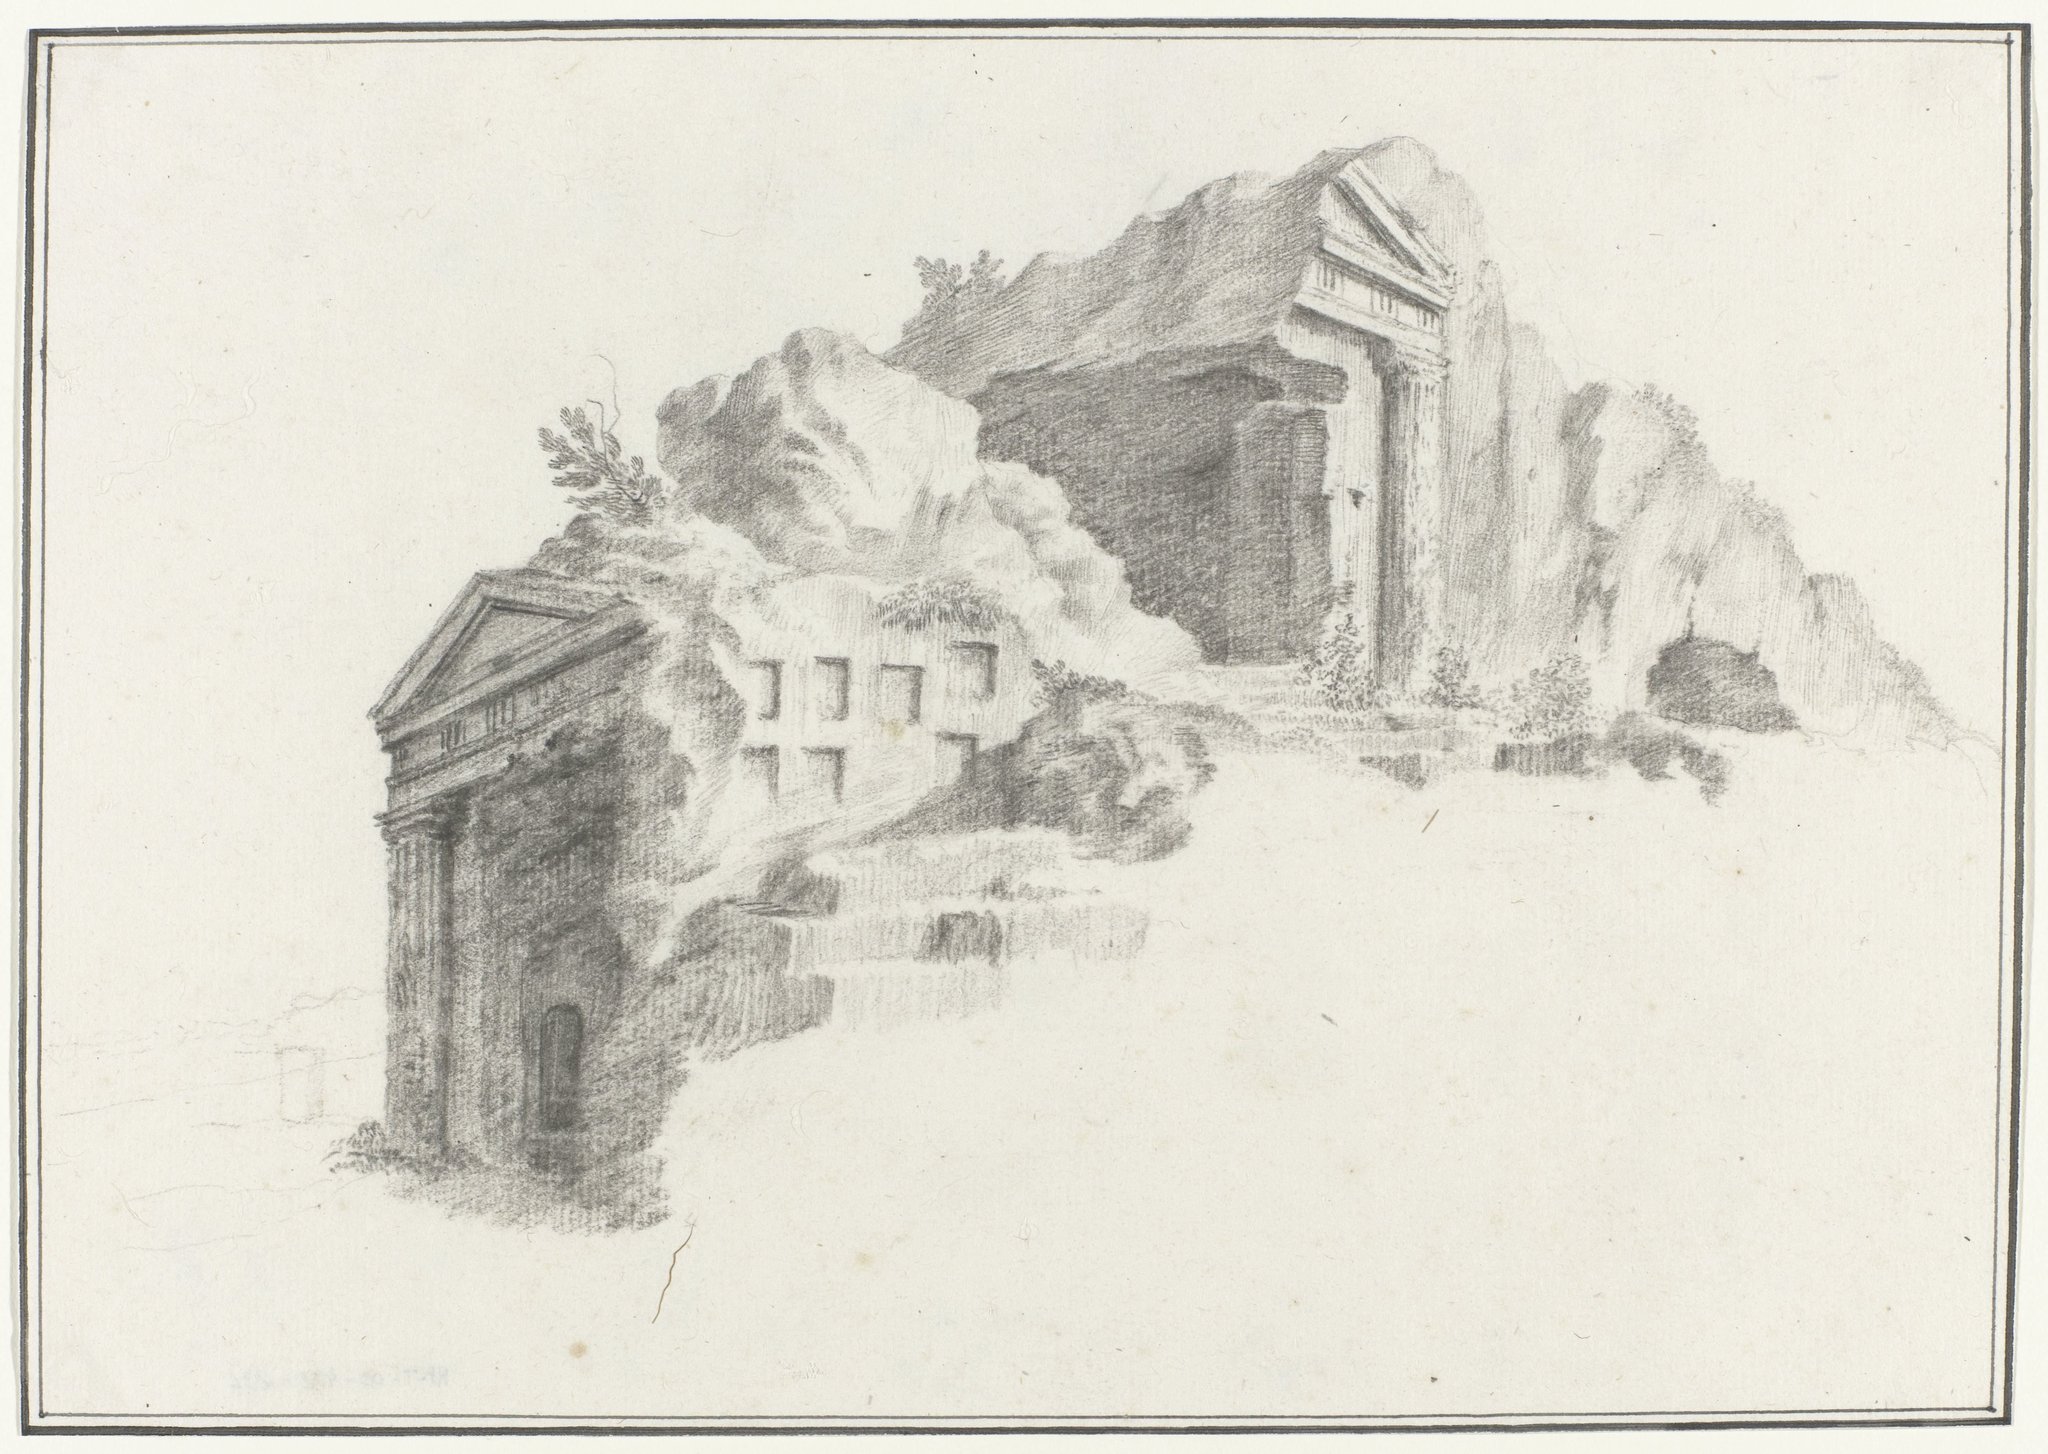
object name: drawing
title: Voyage en Italie, en Sicile et à Malte - 1778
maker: louis mayer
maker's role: draughtsman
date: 1778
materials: chalk, paper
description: Tekening uit het album 'Voyage en Italie, en Sicile et à Malte', 1778.